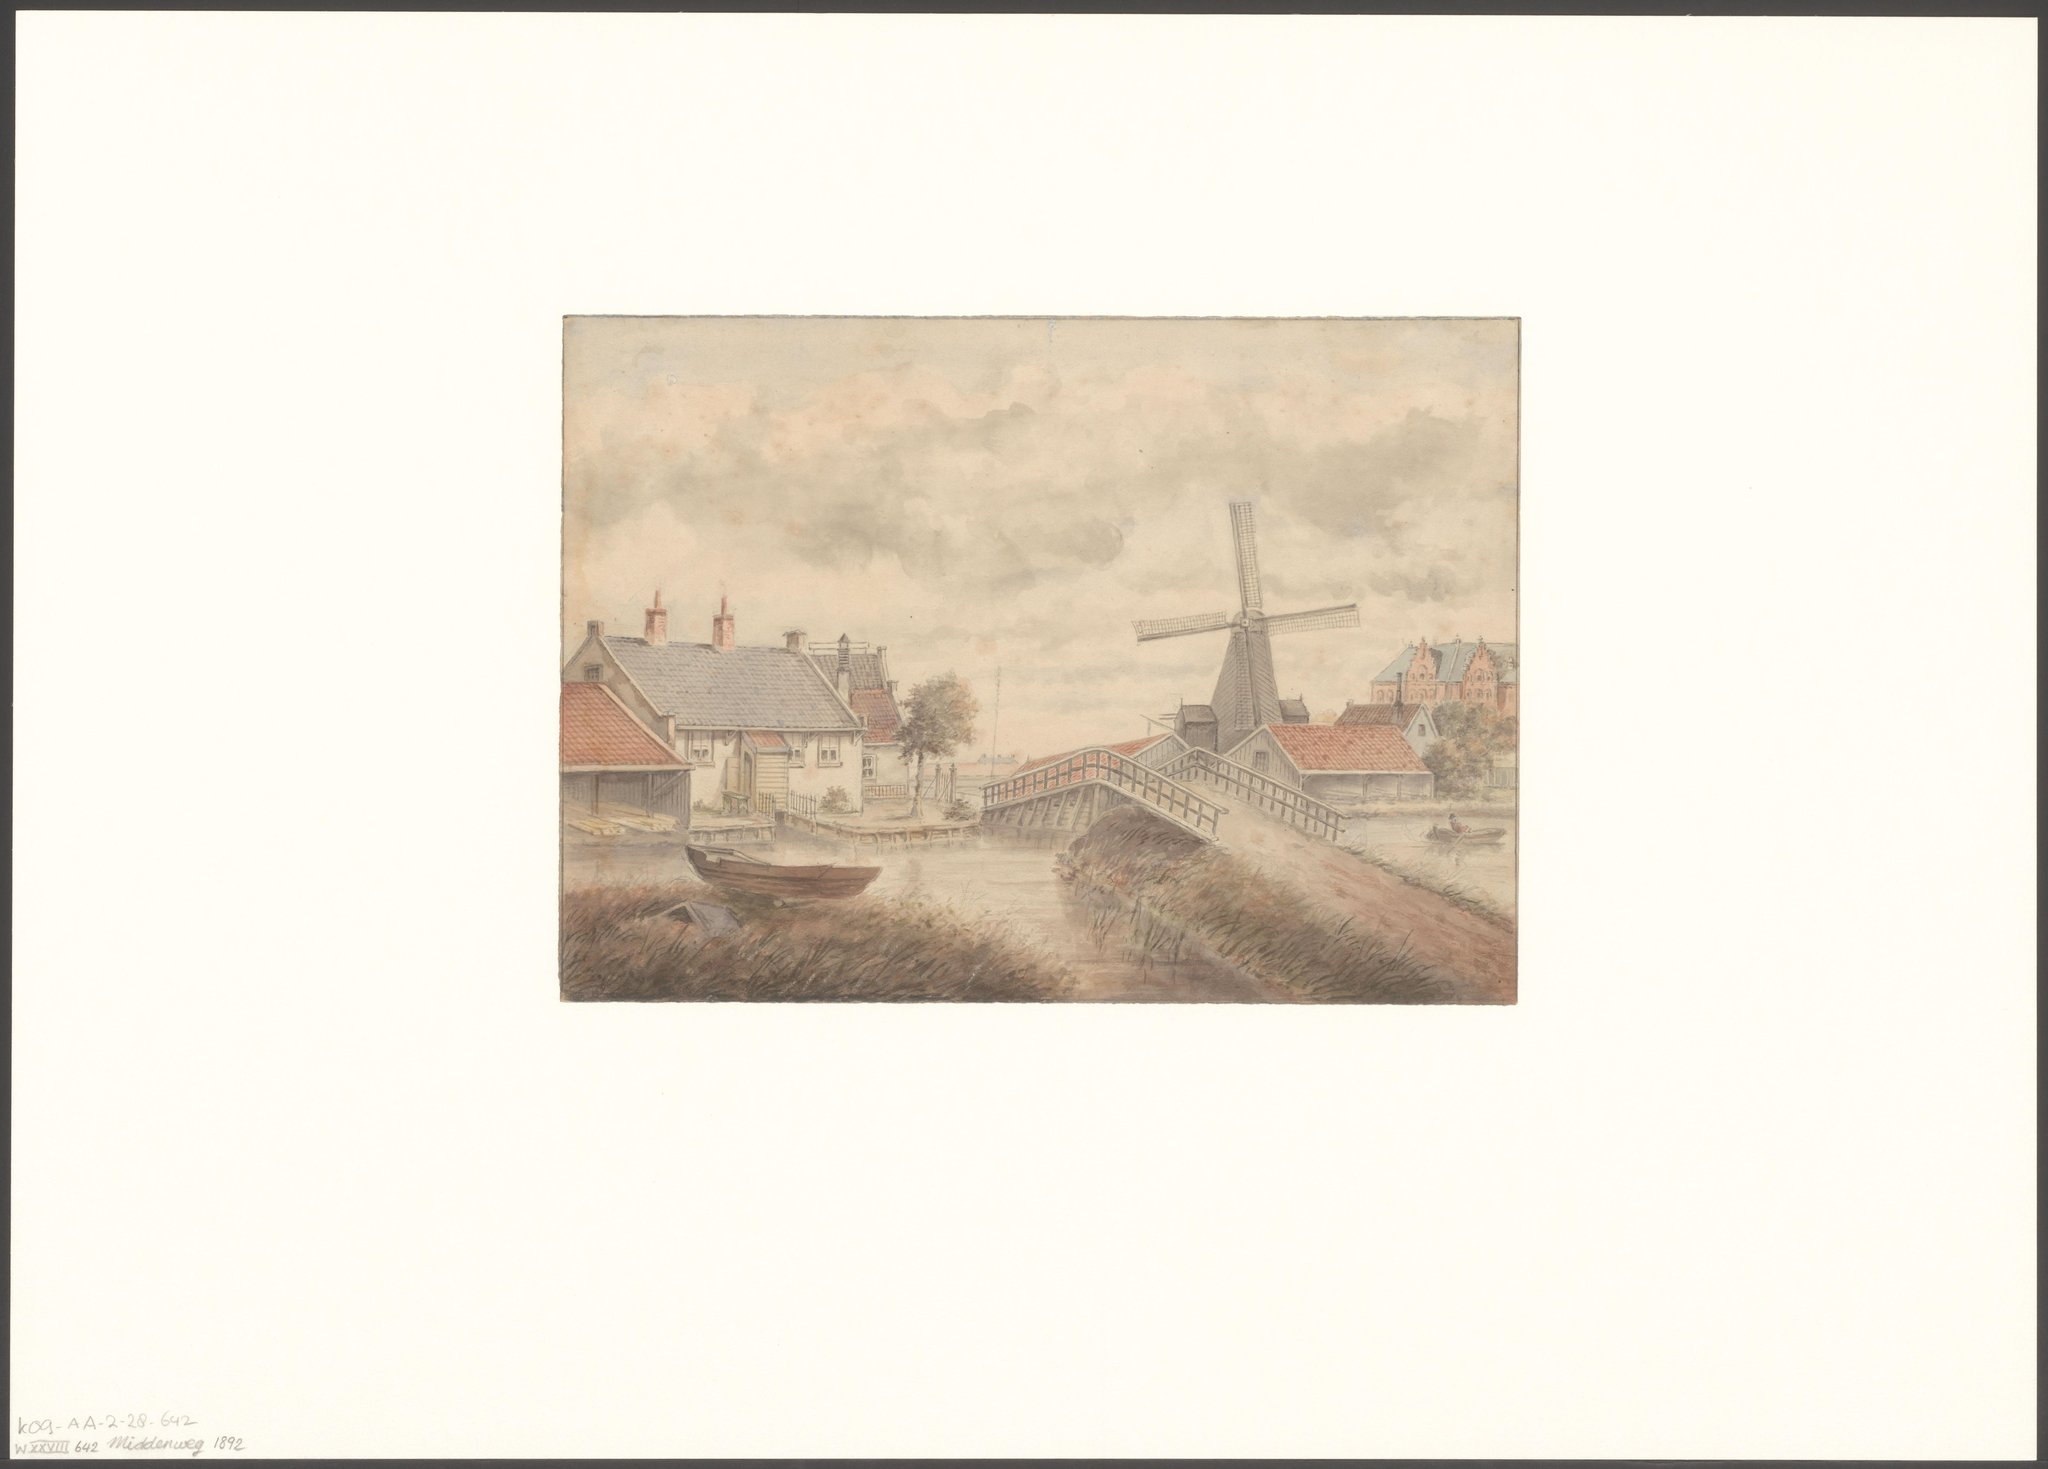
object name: drawing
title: Gezicht op de Middenweg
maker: albert martin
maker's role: draughtsman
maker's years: 1827-1900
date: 1892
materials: paper, pencil, watercolor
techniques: brush, pen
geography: amsterdam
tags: city-view in general; 'veduta', canal, windmill in landscape, shed, bridge in city across river, canal, etc.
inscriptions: collector's mark: Lugt 800a, inscription: ‘Gezicht aan den Middenweg / 1892.’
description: Tekening binnen de Atlas Van Eck ingedeeld op wijknummer 28.